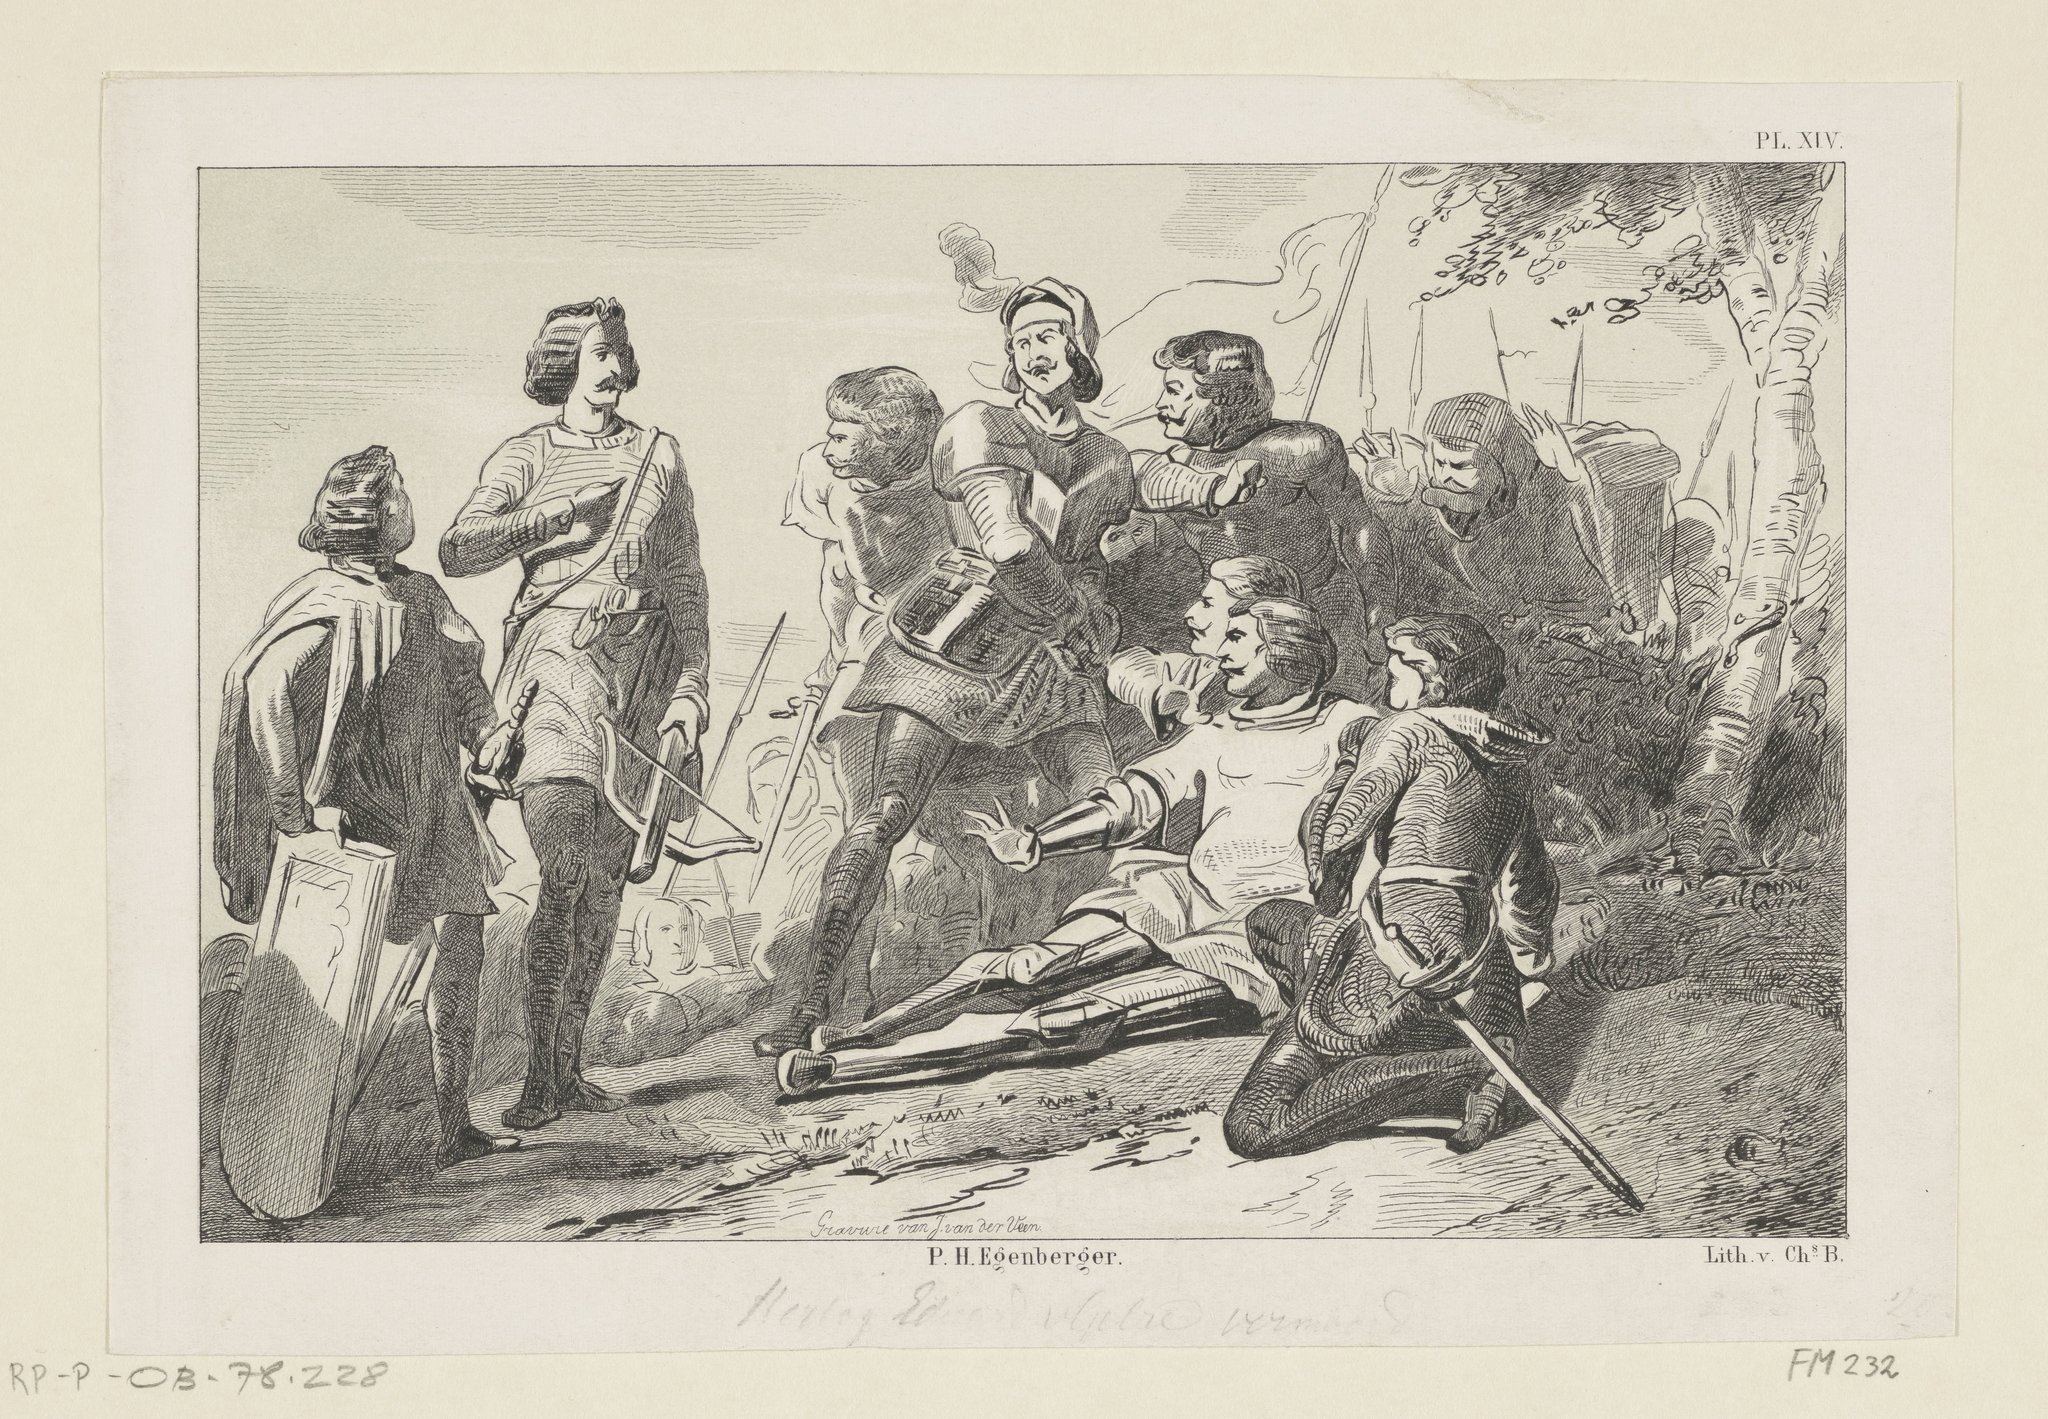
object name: print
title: Hertog Eduard van Gelre vermoord door Herman Bier, 1371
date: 1853-1855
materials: paper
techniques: lithograph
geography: netherlands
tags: eduard (hertog van gelre), violent death, being killed; being mishandled and maltreated; seeking death, burgundian netherlands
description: Eduard, hertog van Gelre wordt na de slag met de Brabanders bij Baesweiler vermoord door zijn jaloerse gunsteling Herman Bier, 22 augustus 1371. Een groep ridders rust uit na de veldslag.